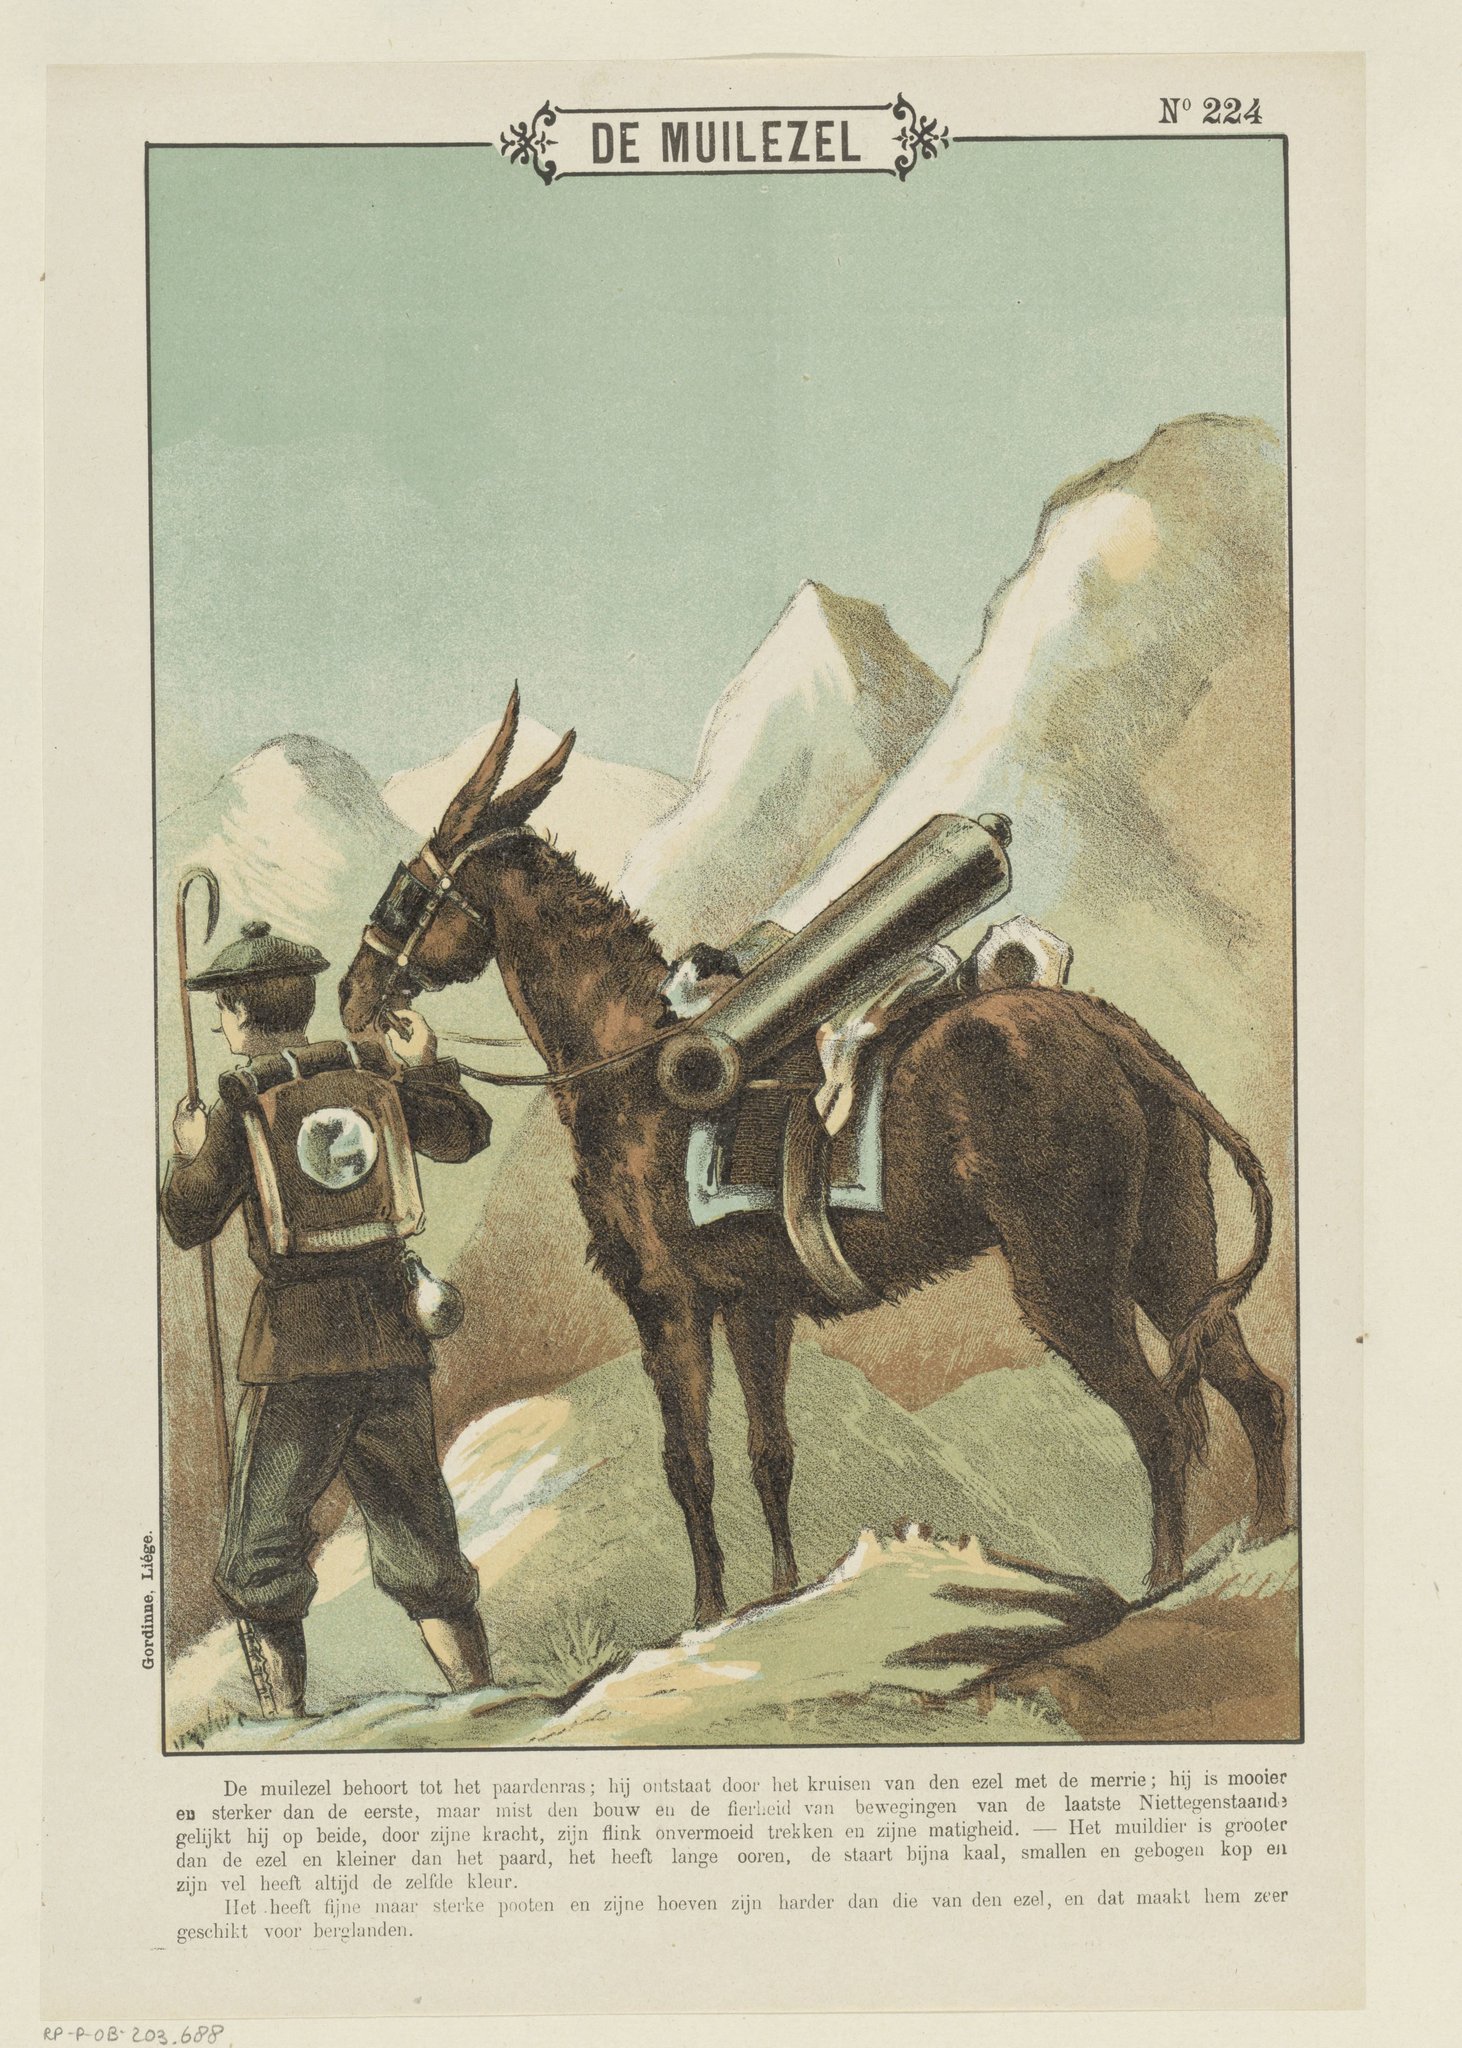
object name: popular print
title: De muilezel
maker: Anonymous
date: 1894-1959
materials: paper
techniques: lithograph, letterpress printing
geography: liège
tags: mule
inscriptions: collector's mark: Lugt 2760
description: Blad met een grote voorstelling van een muilezel en een reiziger in de bergen. In de ondermarge een onderschrift. Genummerd rechtsboven: No 224.